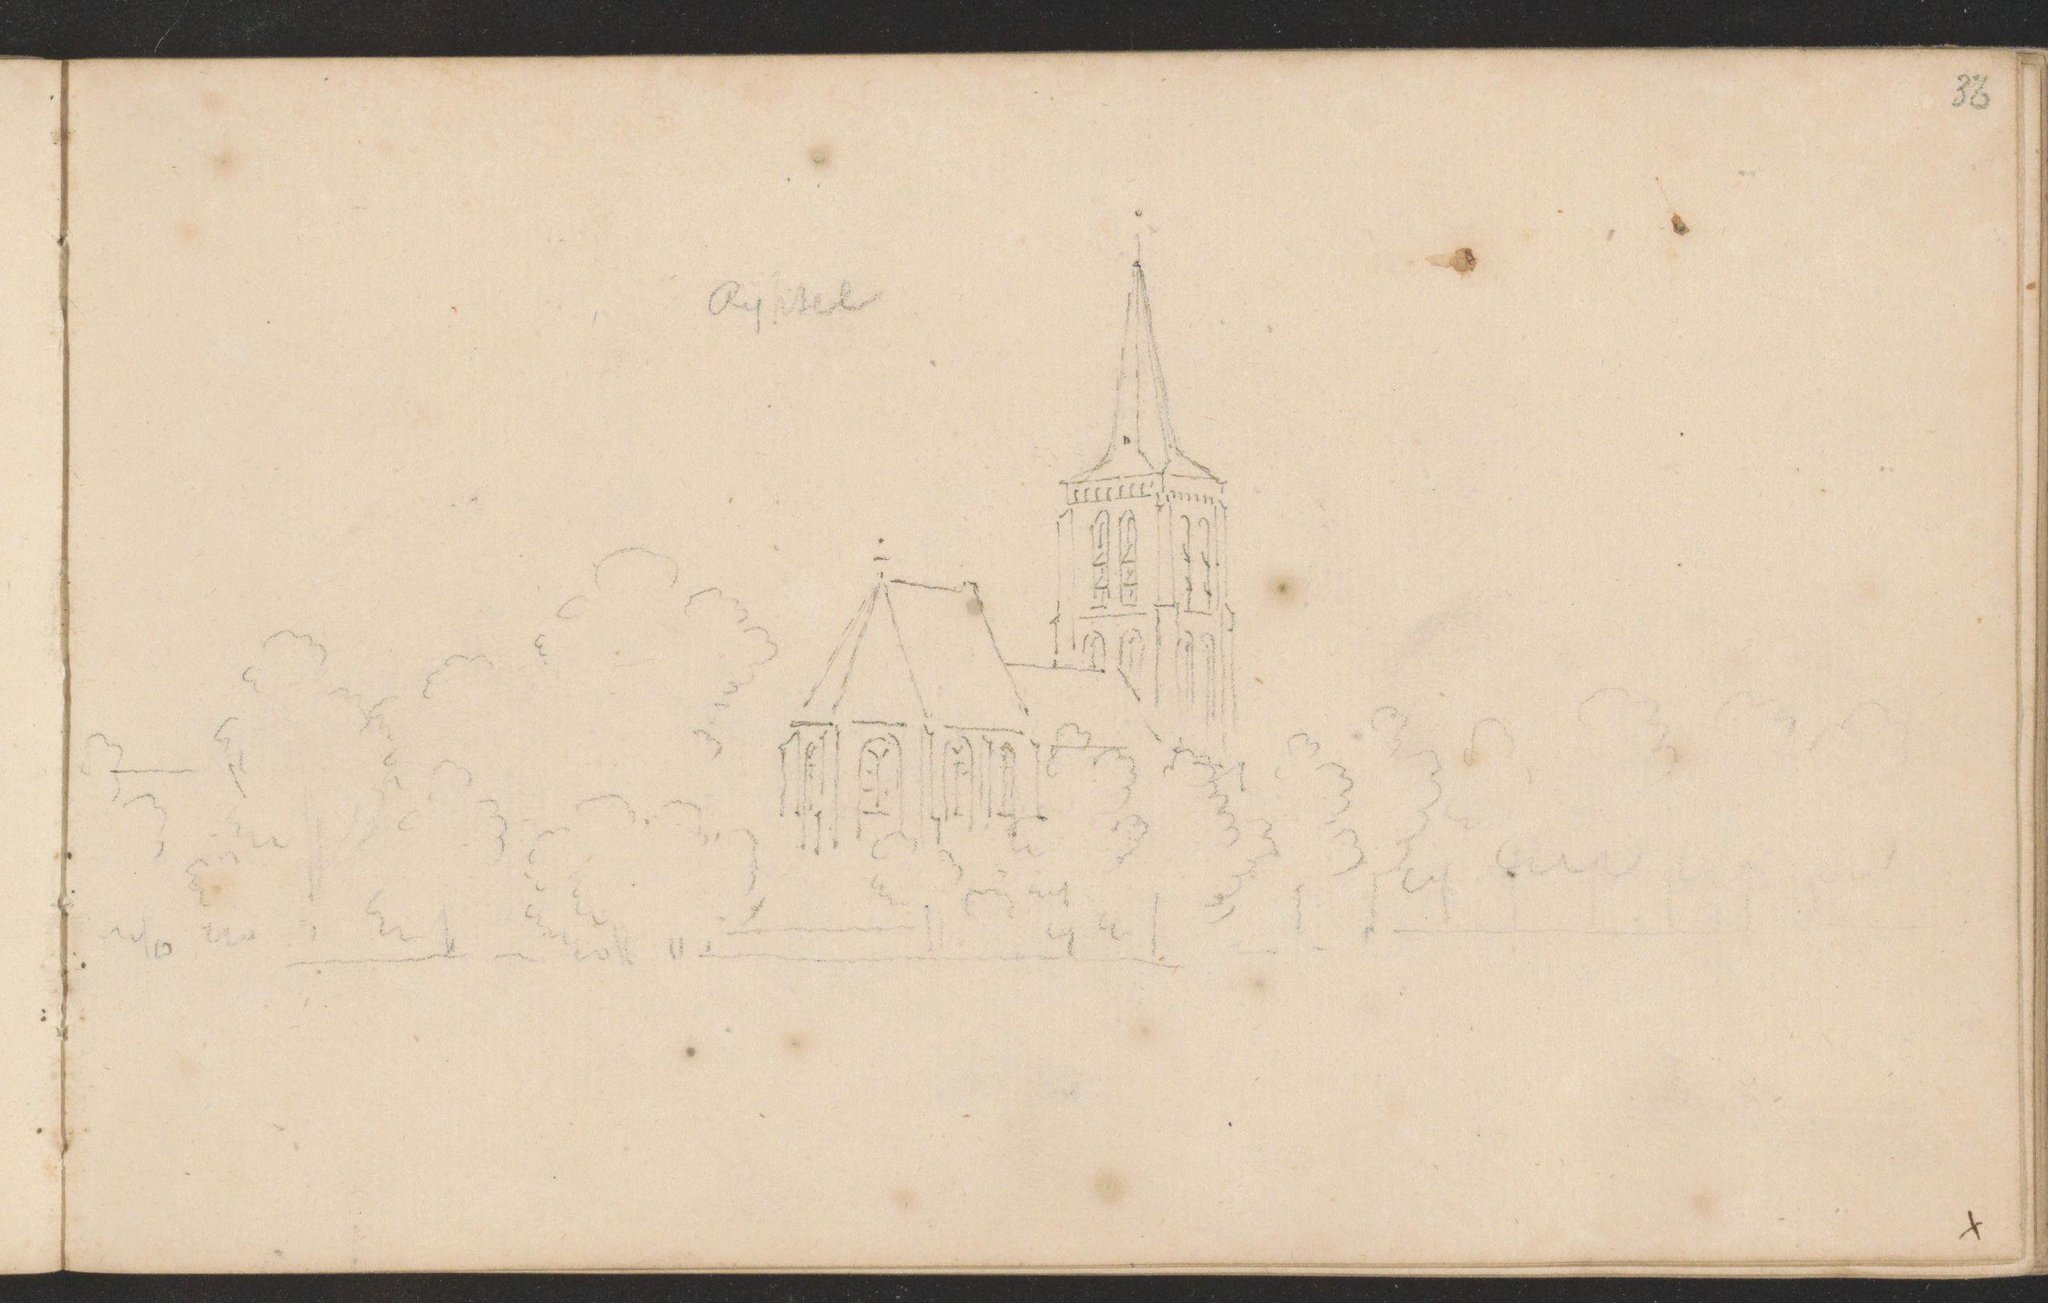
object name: sketchbook leaf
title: Kerk van Rixtel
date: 1701-1759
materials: paper, pencil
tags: church (exterior)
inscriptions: annotation: ‘Rijkstel’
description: Blad 36 recto uit een schetsboek met 65 bladen.